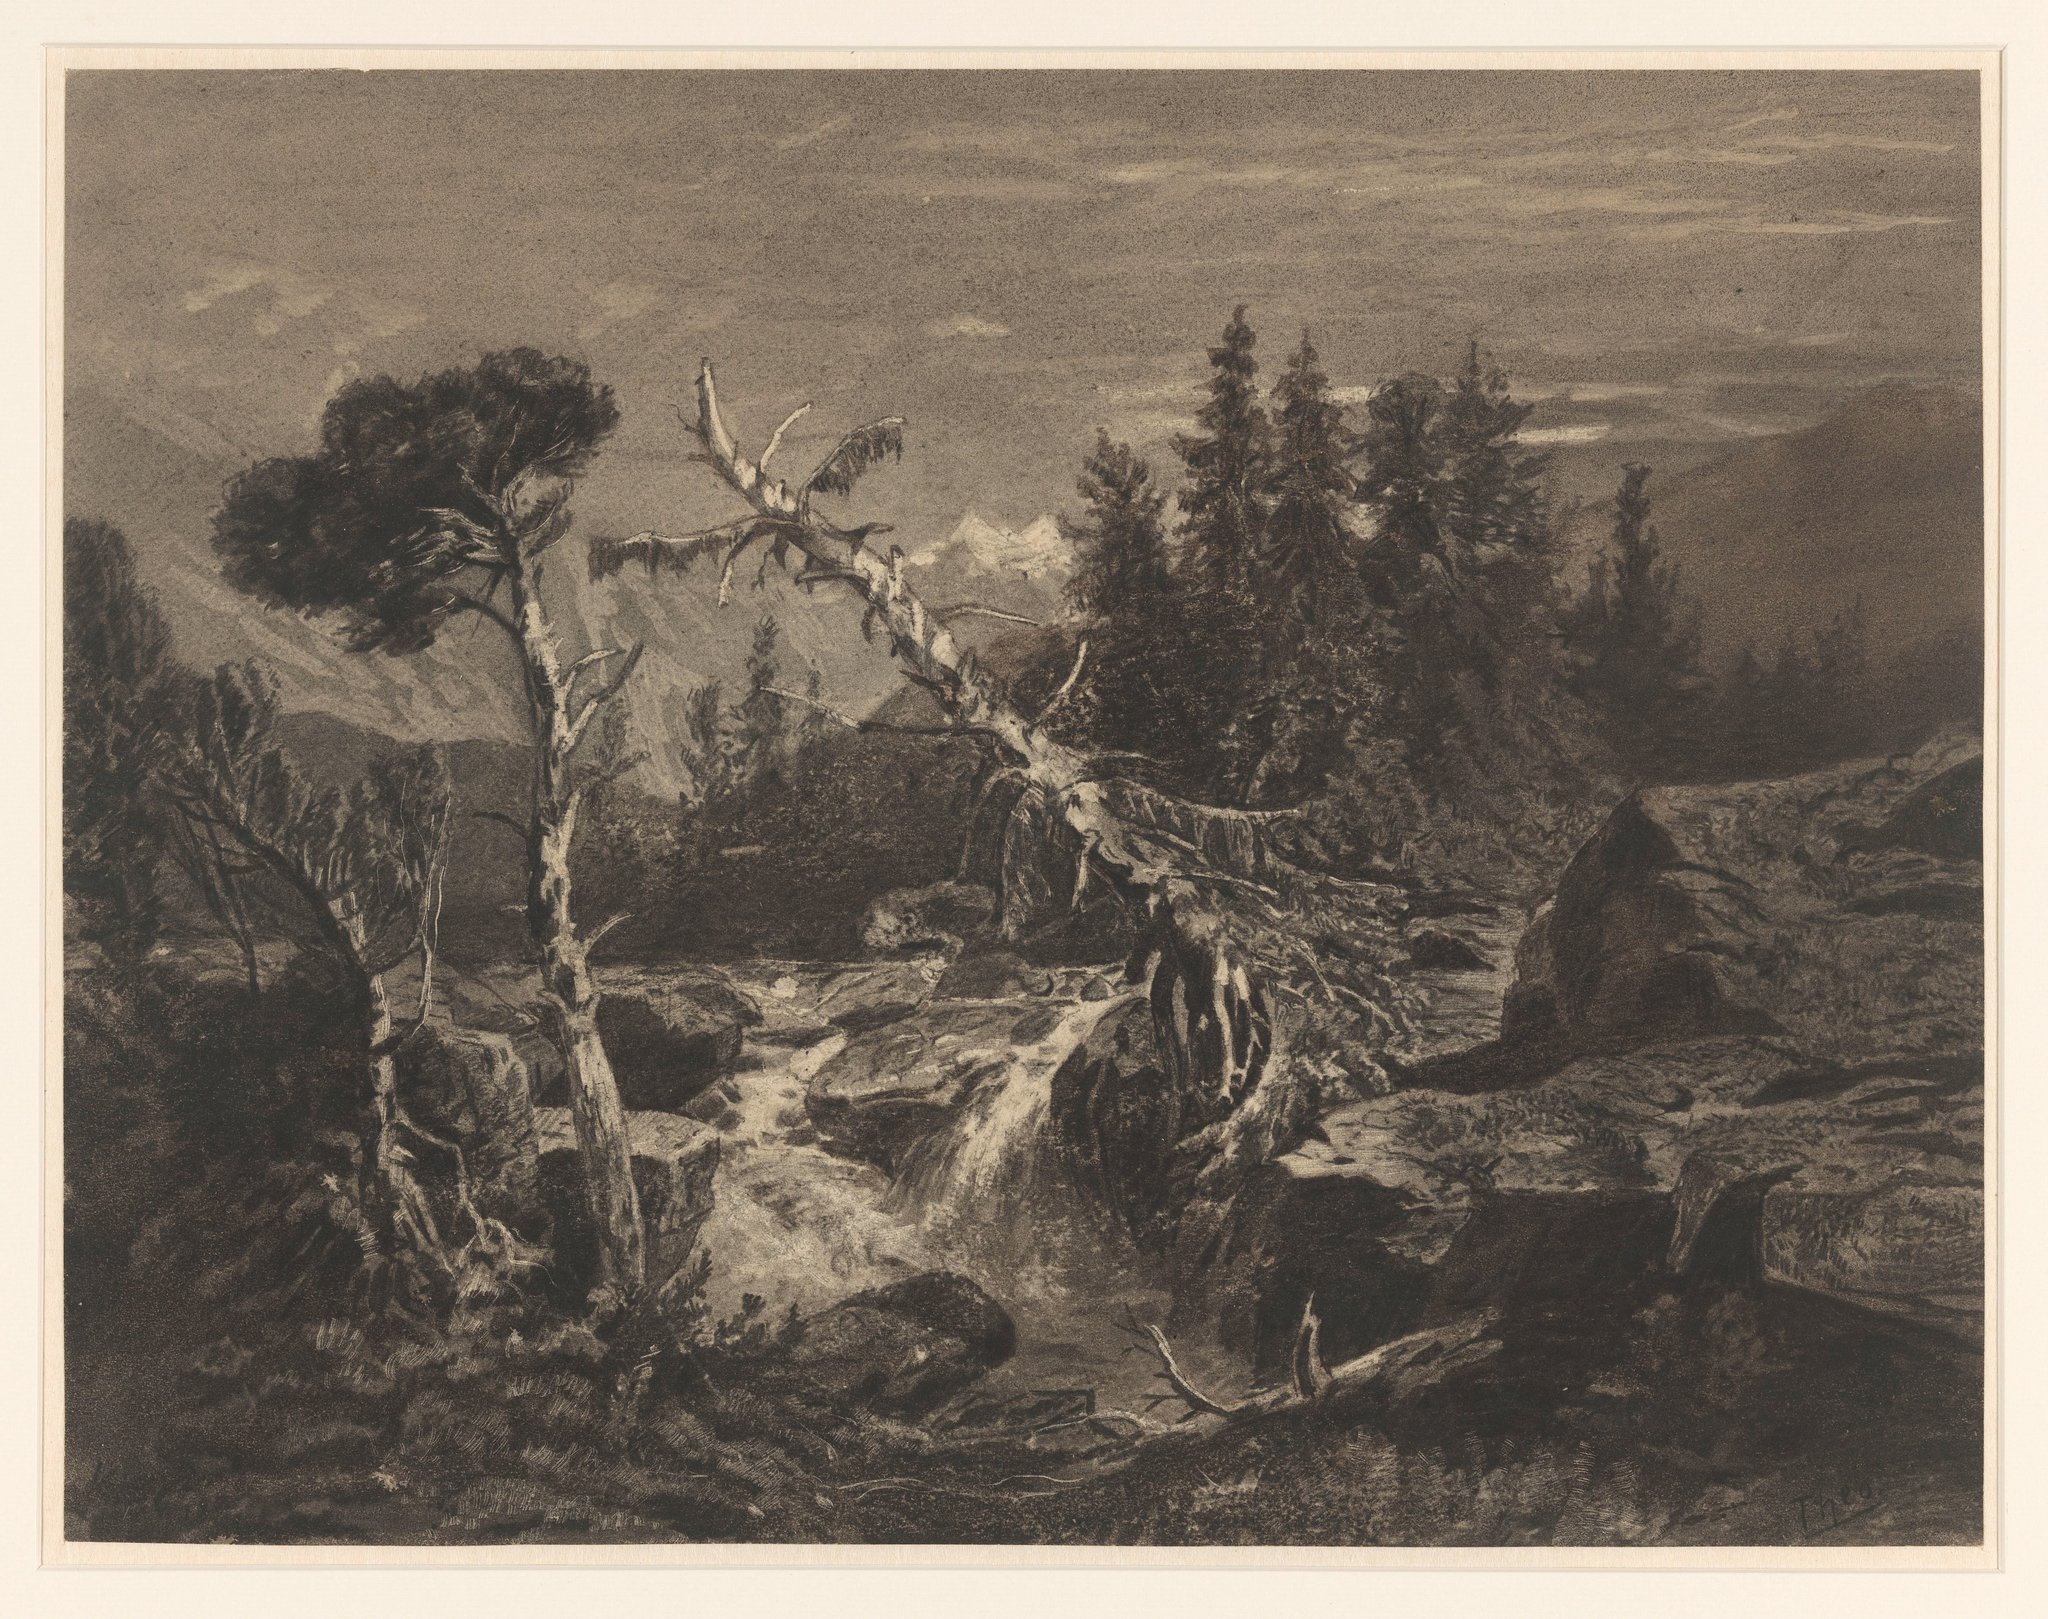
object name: drawing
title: Bergachtig landschap met waterval en boomstronken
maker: theo van hoytema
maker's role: draughtsman, painter, print maker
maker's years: 1863-1917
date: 1873-1917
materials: chalk, charcoal, paper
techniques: brush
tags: waterfall, mountains